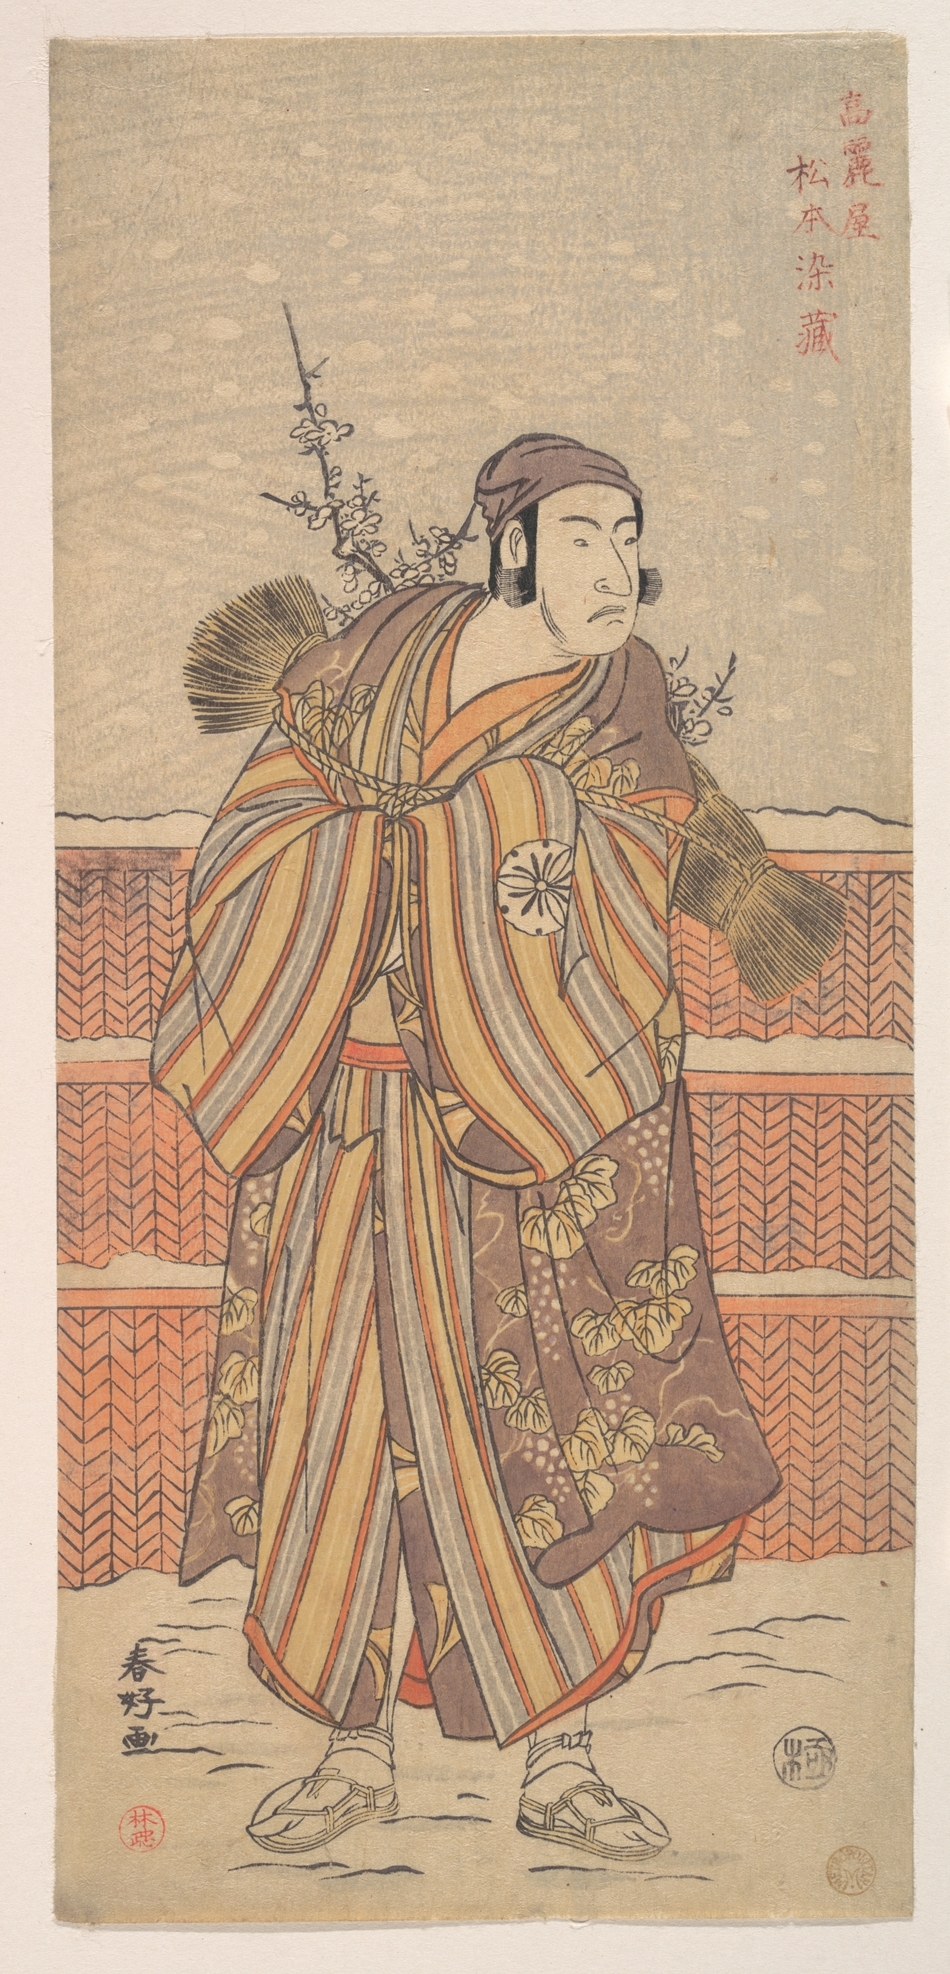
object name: print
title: Matsumoto Sumezō as a Man in Winter Attire Standing in the Snow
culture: japanese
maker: katsukawa shunkō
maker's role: artist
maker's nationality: japanese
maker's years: 1743-1812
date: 1785-1790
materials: ink, paper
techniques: woodblock print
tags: men,snow,actors